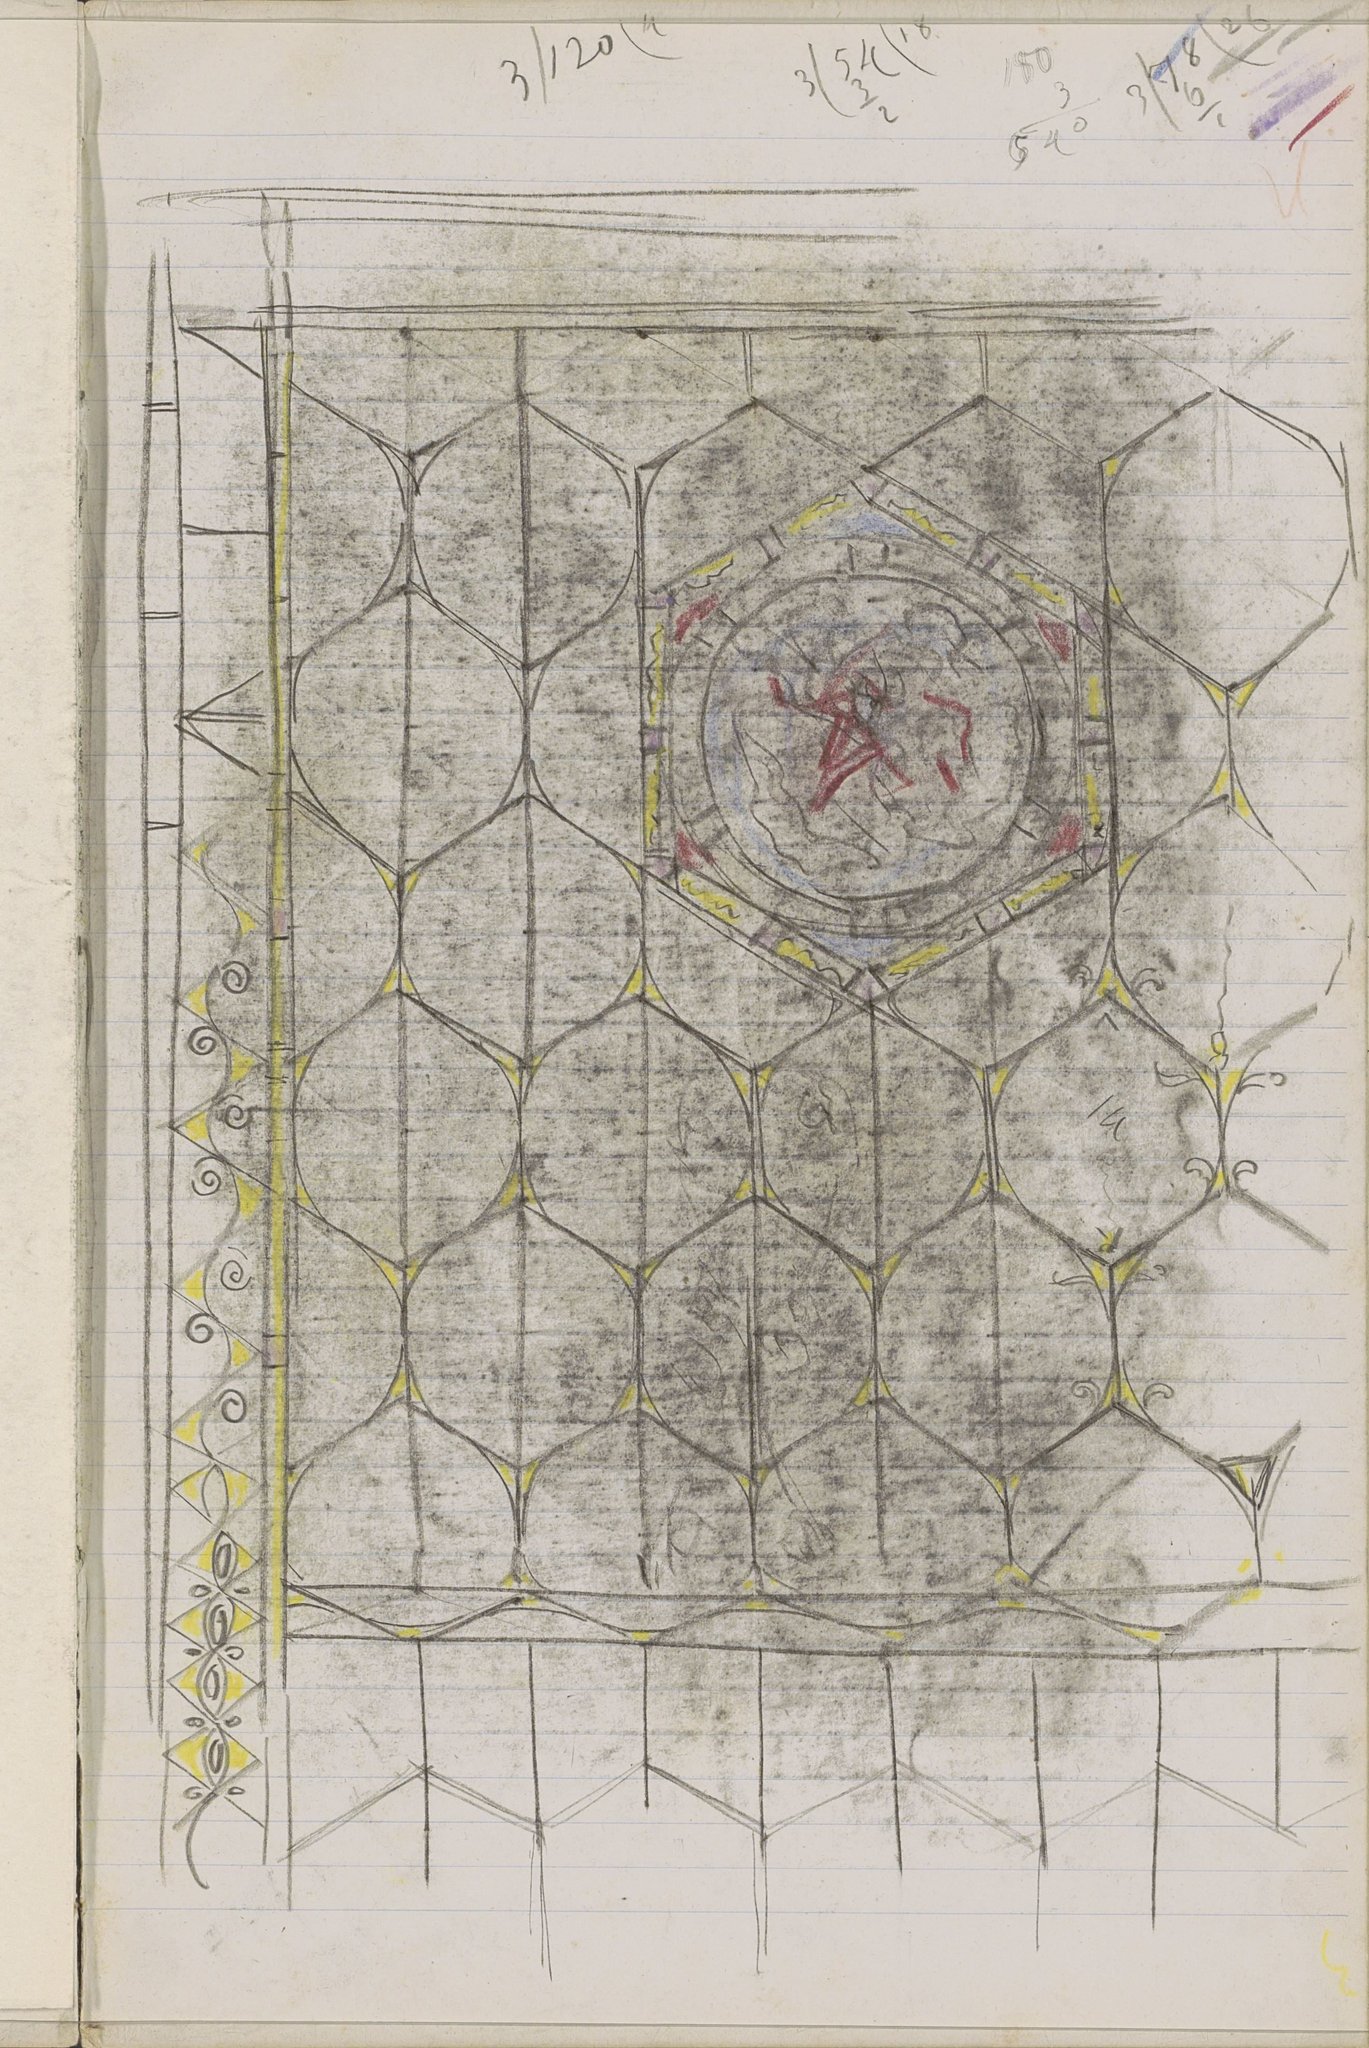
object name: sketchbook leaf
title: Ontwerp voor een glas-in-loodvenster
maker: gerrit willem dijsselhof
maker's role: designer, draughtsman, print maker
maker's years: 1866-1924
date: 1901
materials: chalk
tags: work of applied art (+ types of art)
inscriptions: annotation: ‘[...]’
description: Blad 33 recto uit een schetsboek met 79 bladen.